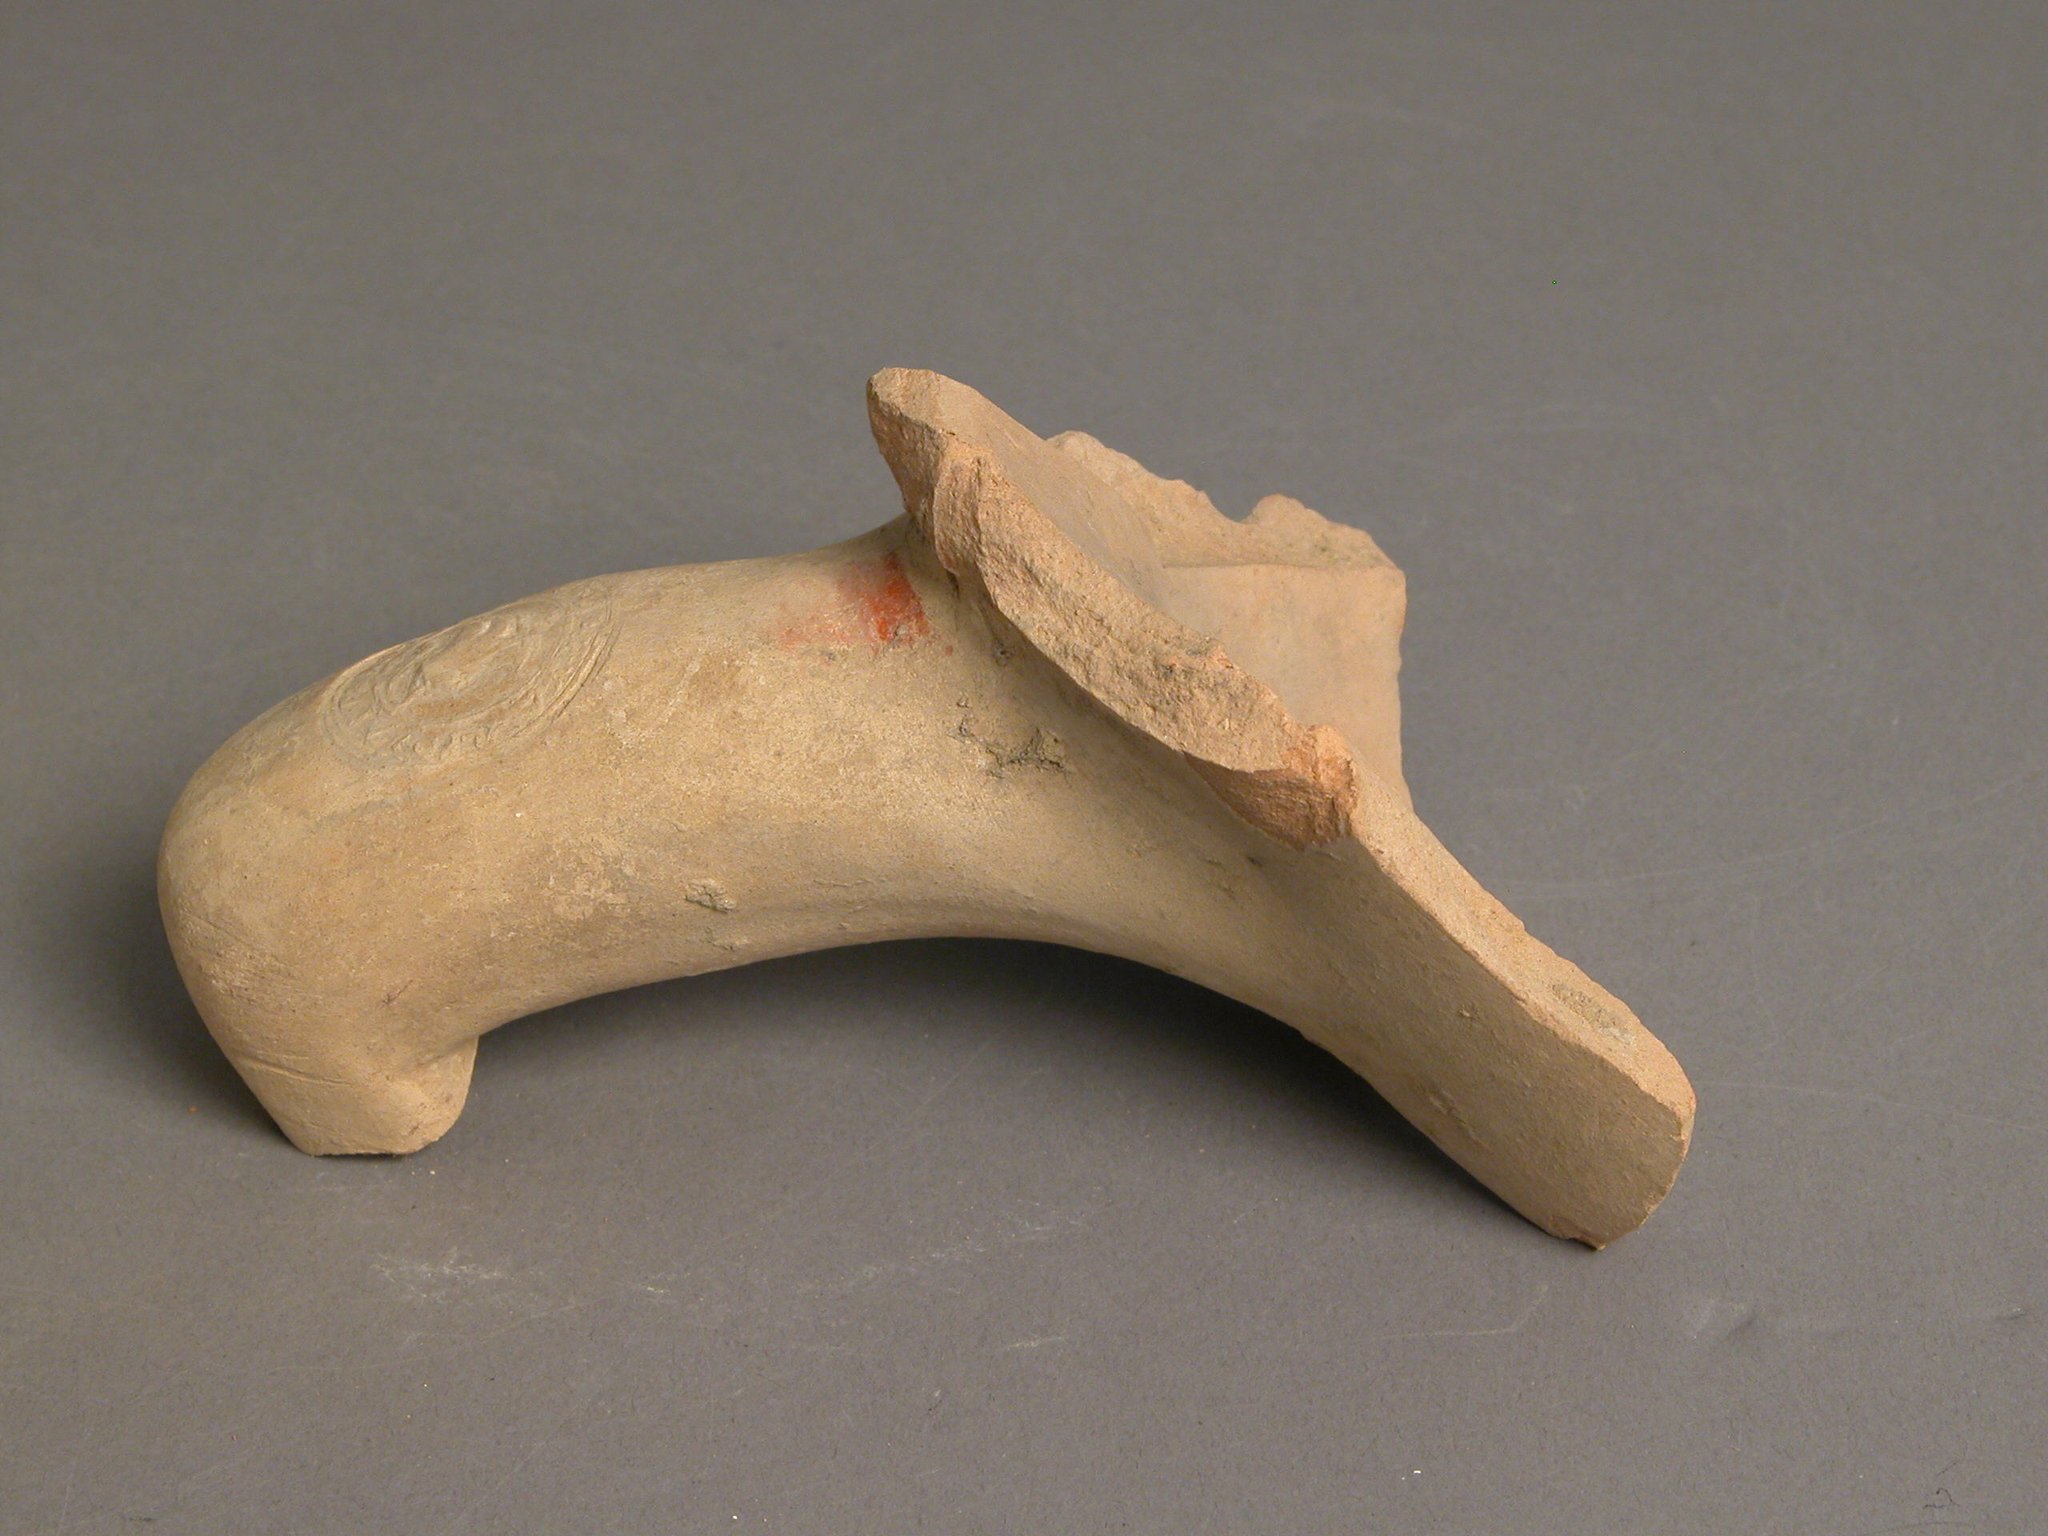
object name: fragment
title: Fragment of a Pot Handle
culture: coptic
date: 301-700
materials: earthenware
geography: egypt